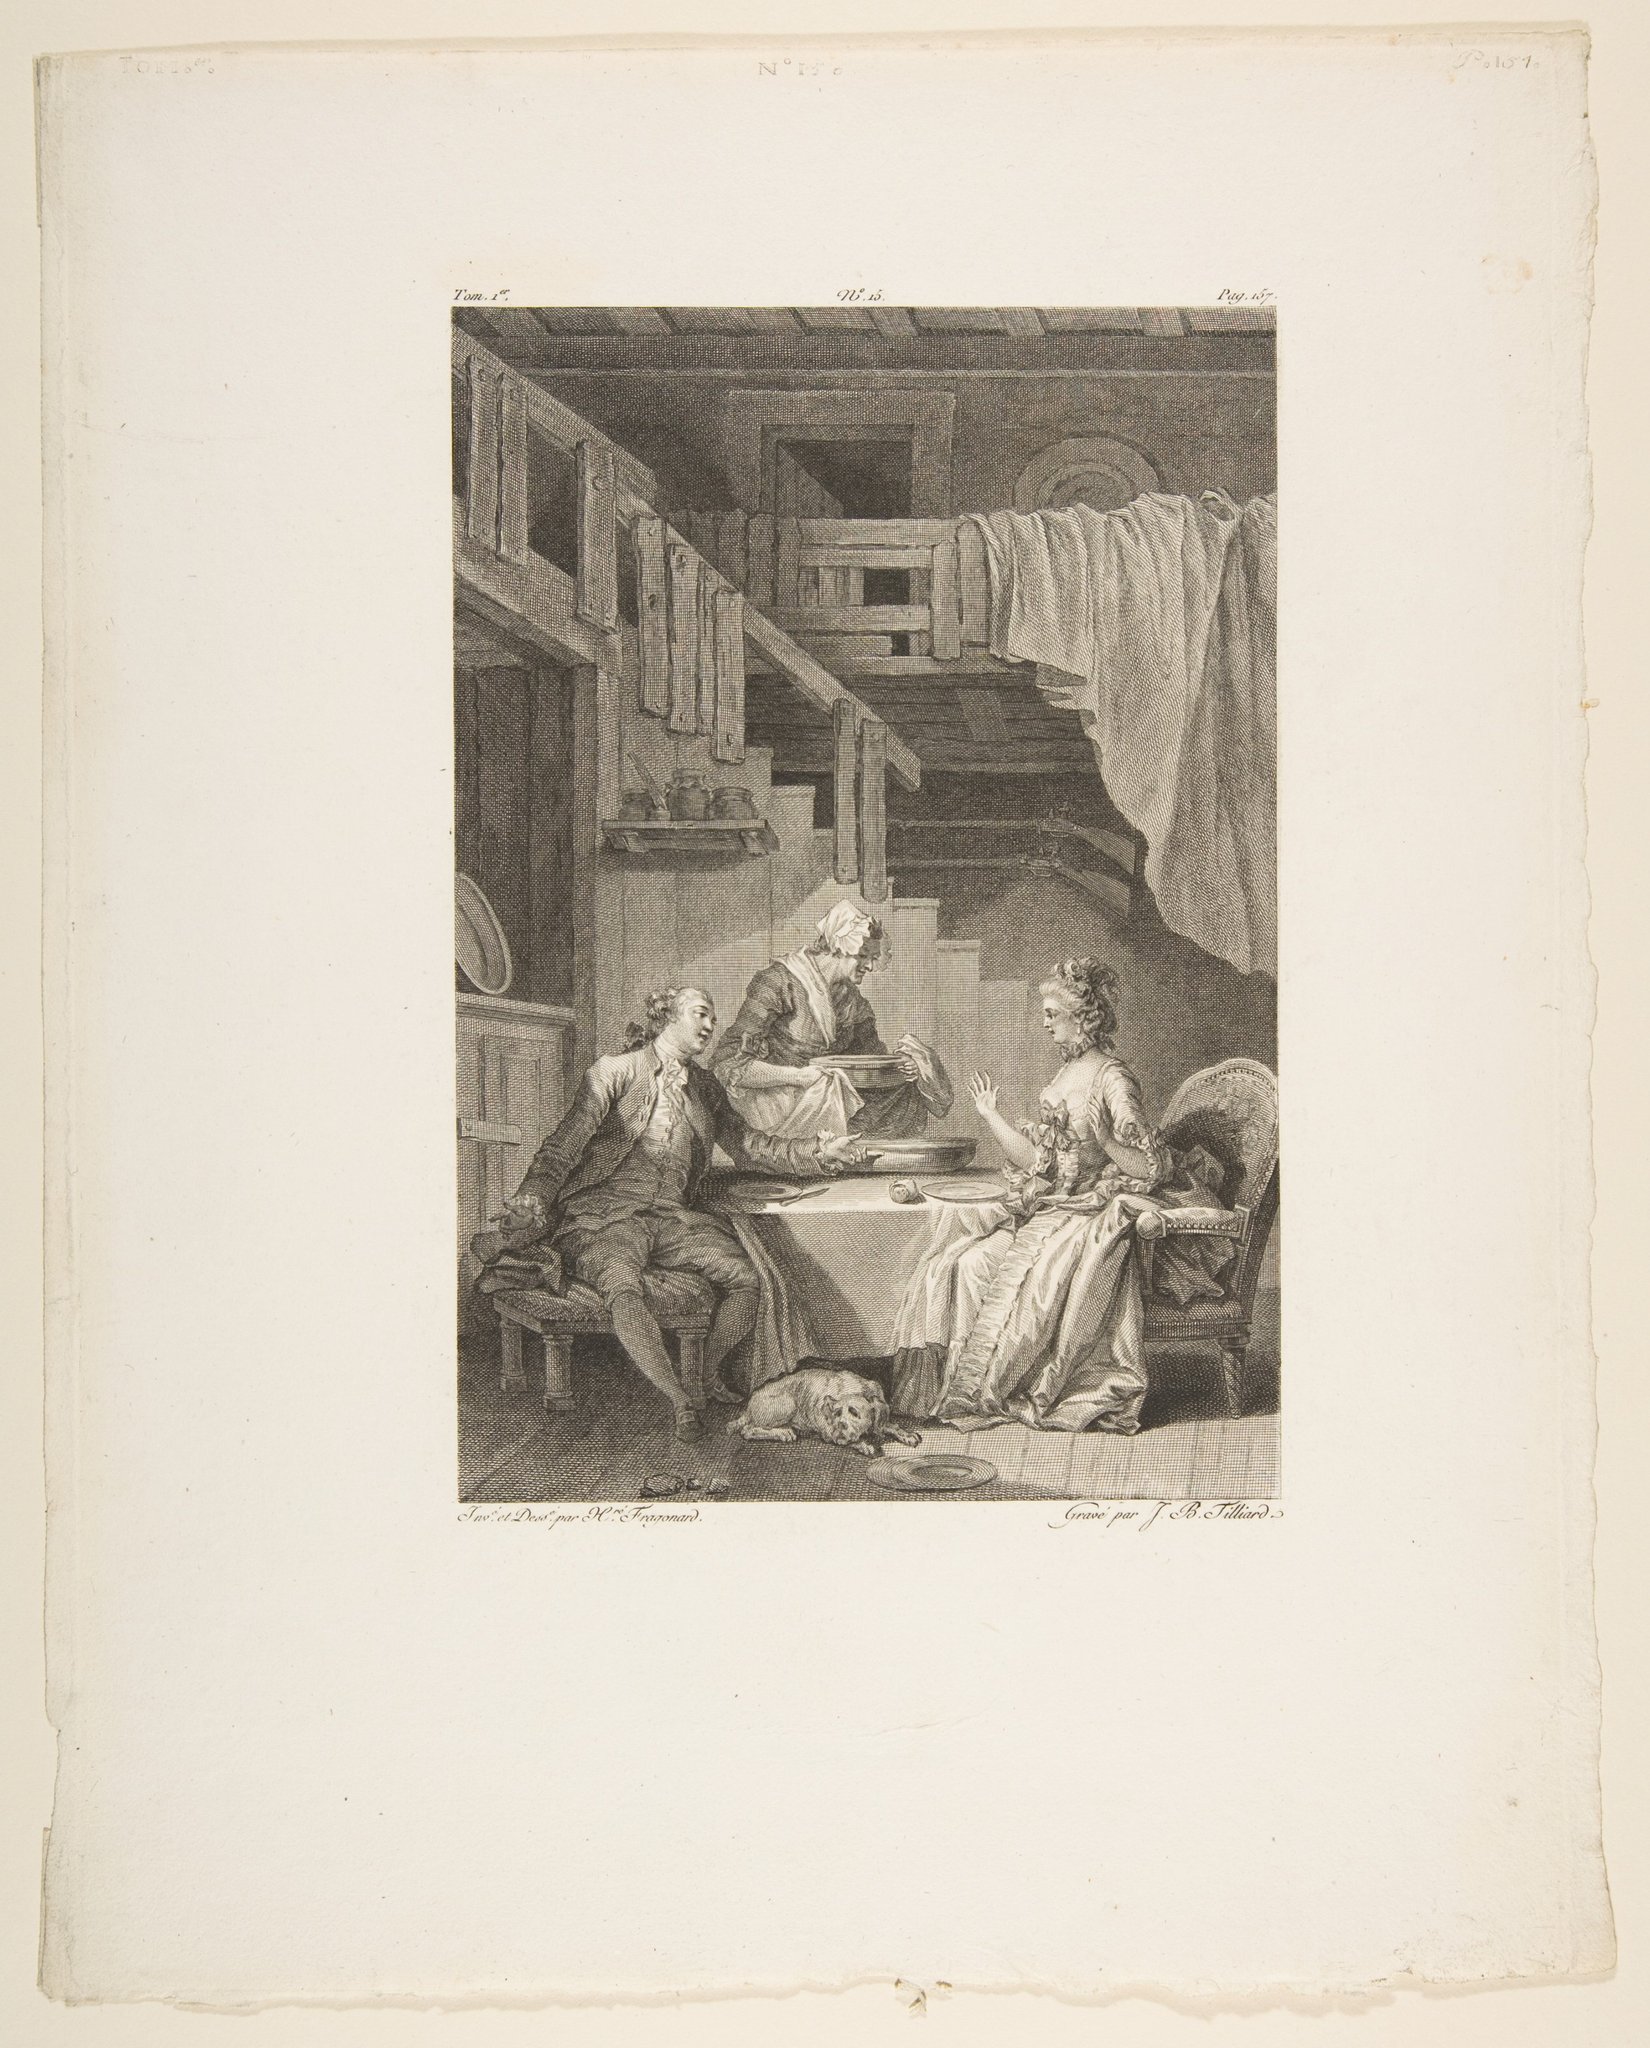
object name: print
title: Le Faucon, from Contes et nouvelles en vers par Jean de La Fontaine. A Paris, de l'imprimerie de P. Didot, l'an III de la République, 1795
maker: jean-baptiste tilliard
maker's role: artist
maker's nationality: french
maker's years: 1740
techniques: engraving, etching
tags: stairs,dining rooms,men,women,dogs